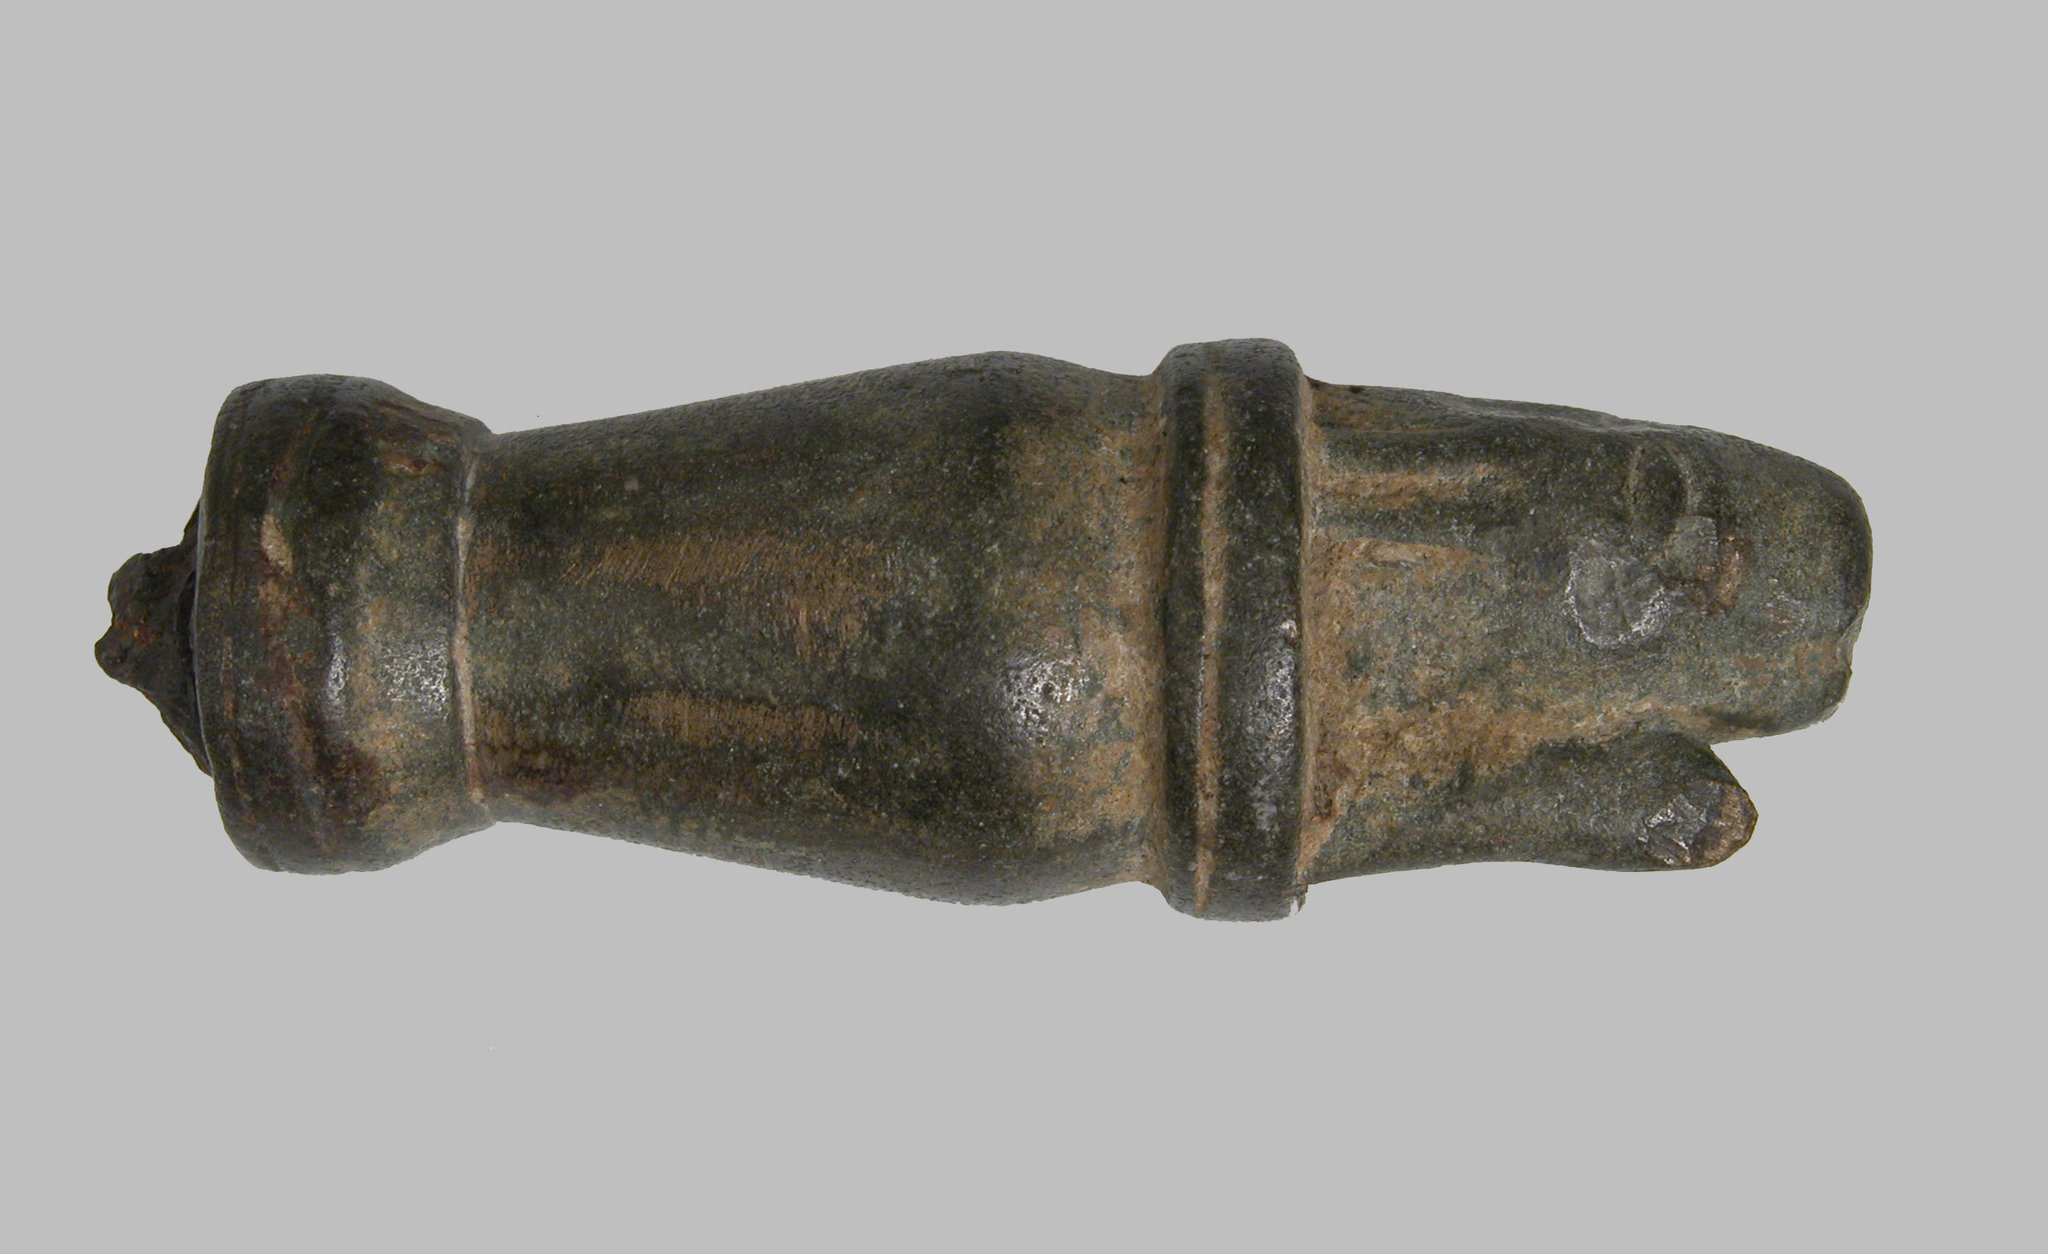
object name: key handle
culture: roman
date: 1-700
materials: copper alloy, iron